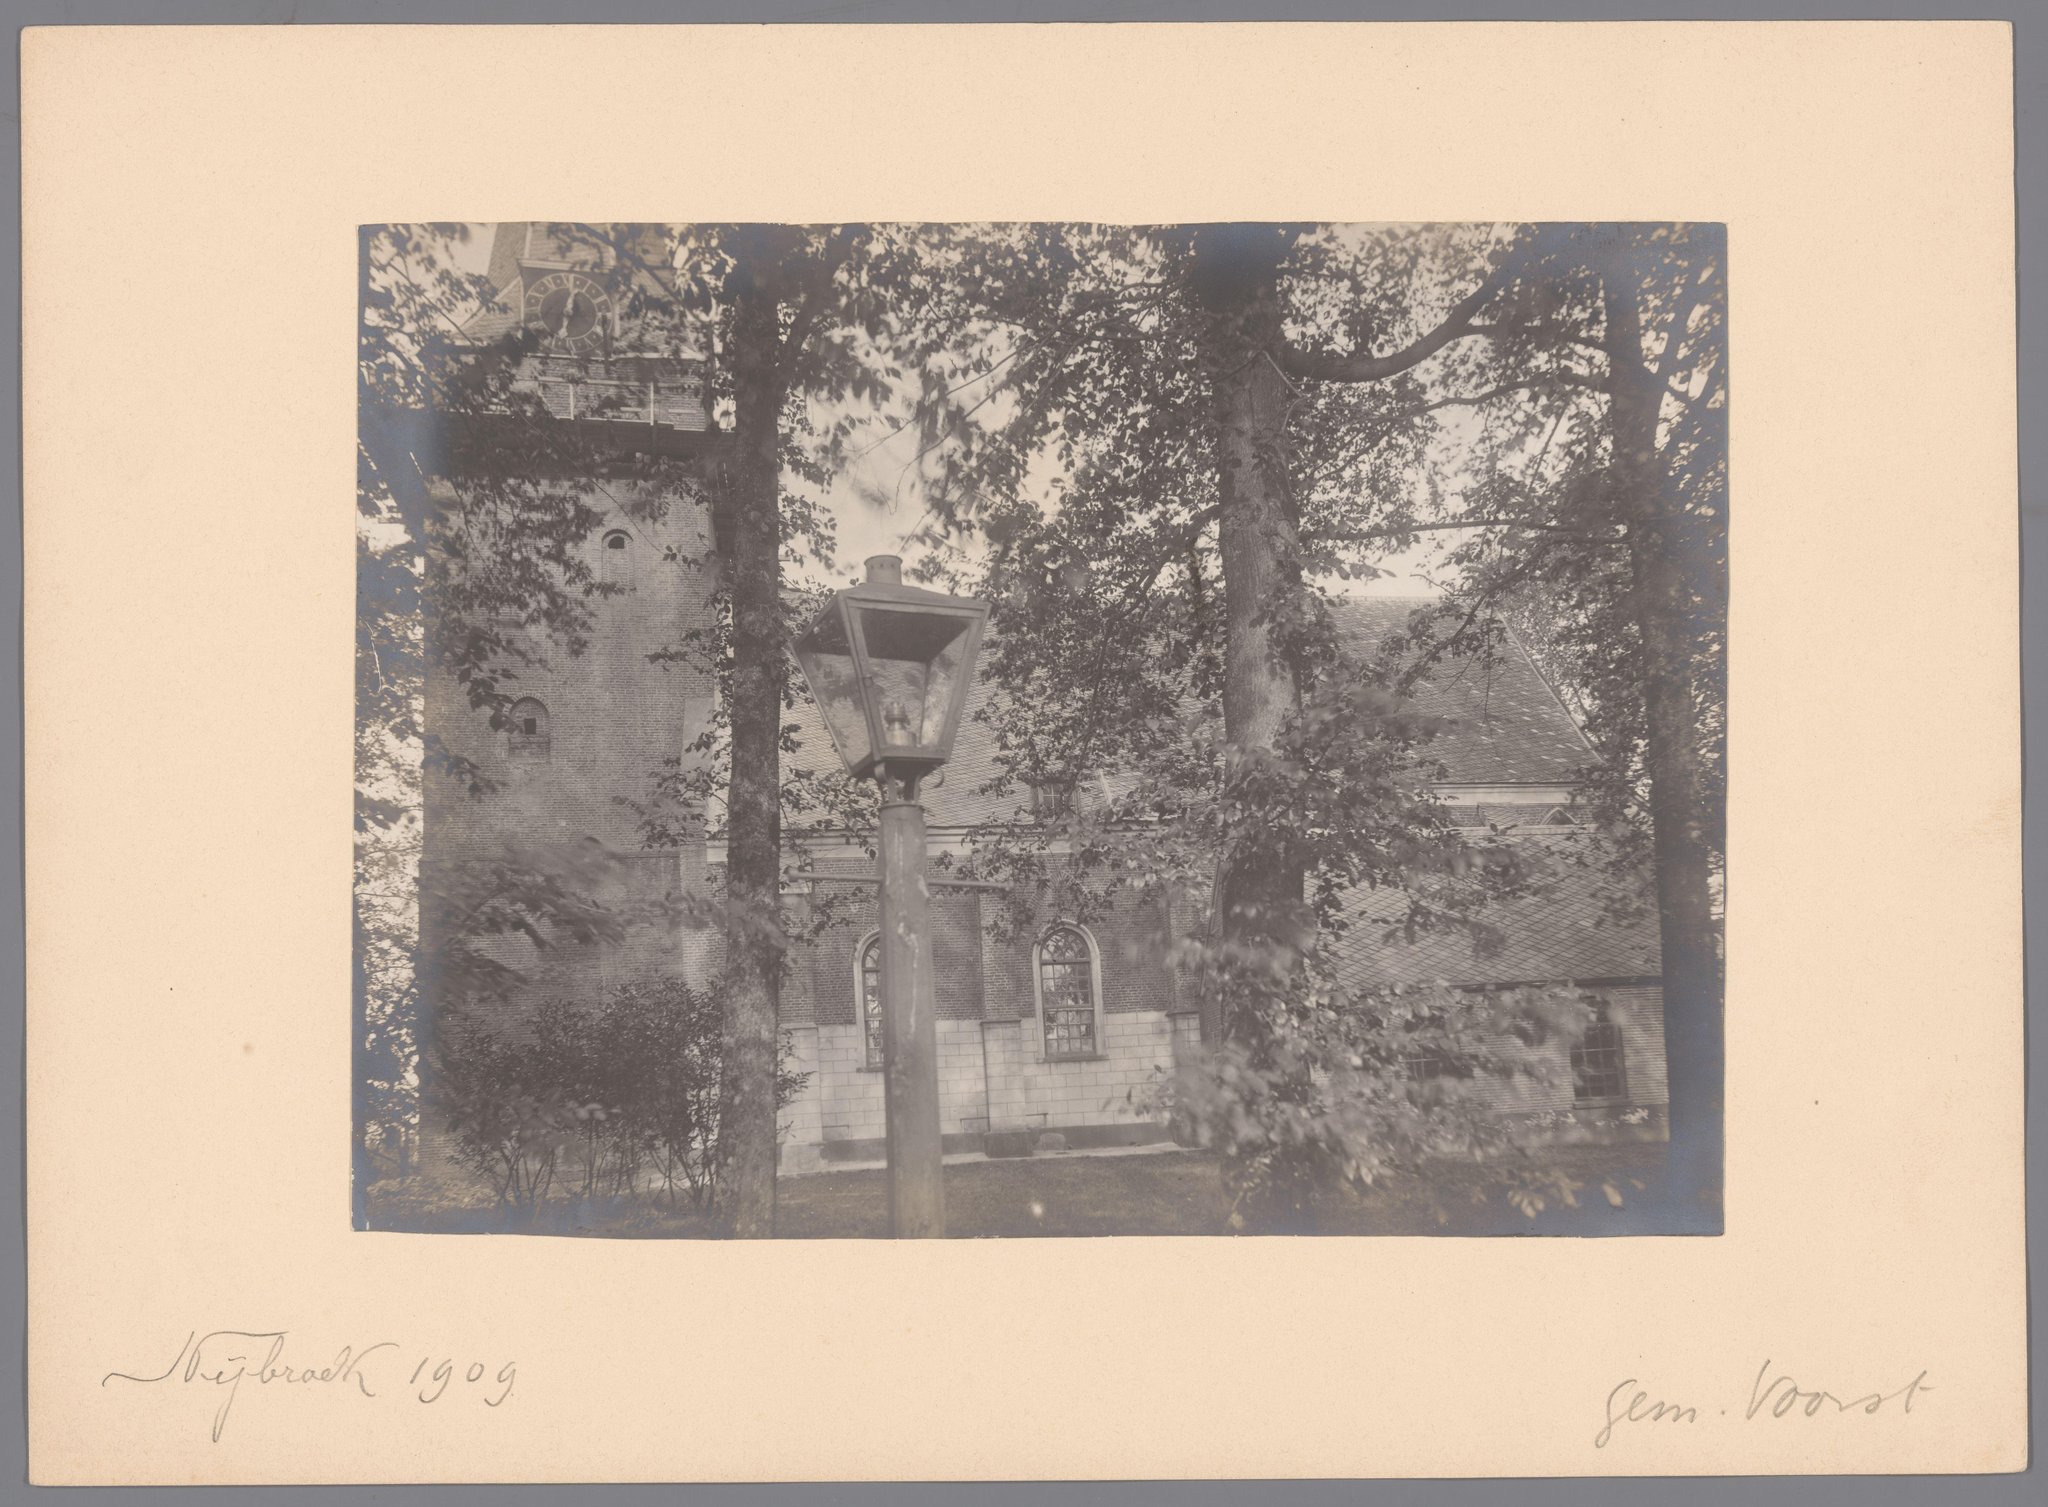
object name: photograph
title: Gezicht op de Hervormde Kerk te Nijbroek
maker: anoniem (monumentenzorg)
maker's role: fotograaf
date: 1909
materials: cardboard, photographic support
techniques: gelatin silver print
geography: nijbroek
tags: church (exterior), street lighting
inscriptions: annotation: ‘R. Clavery/ 1576_1639’, annotation: ‘Nijbroek 1909/ gem. Voorst’